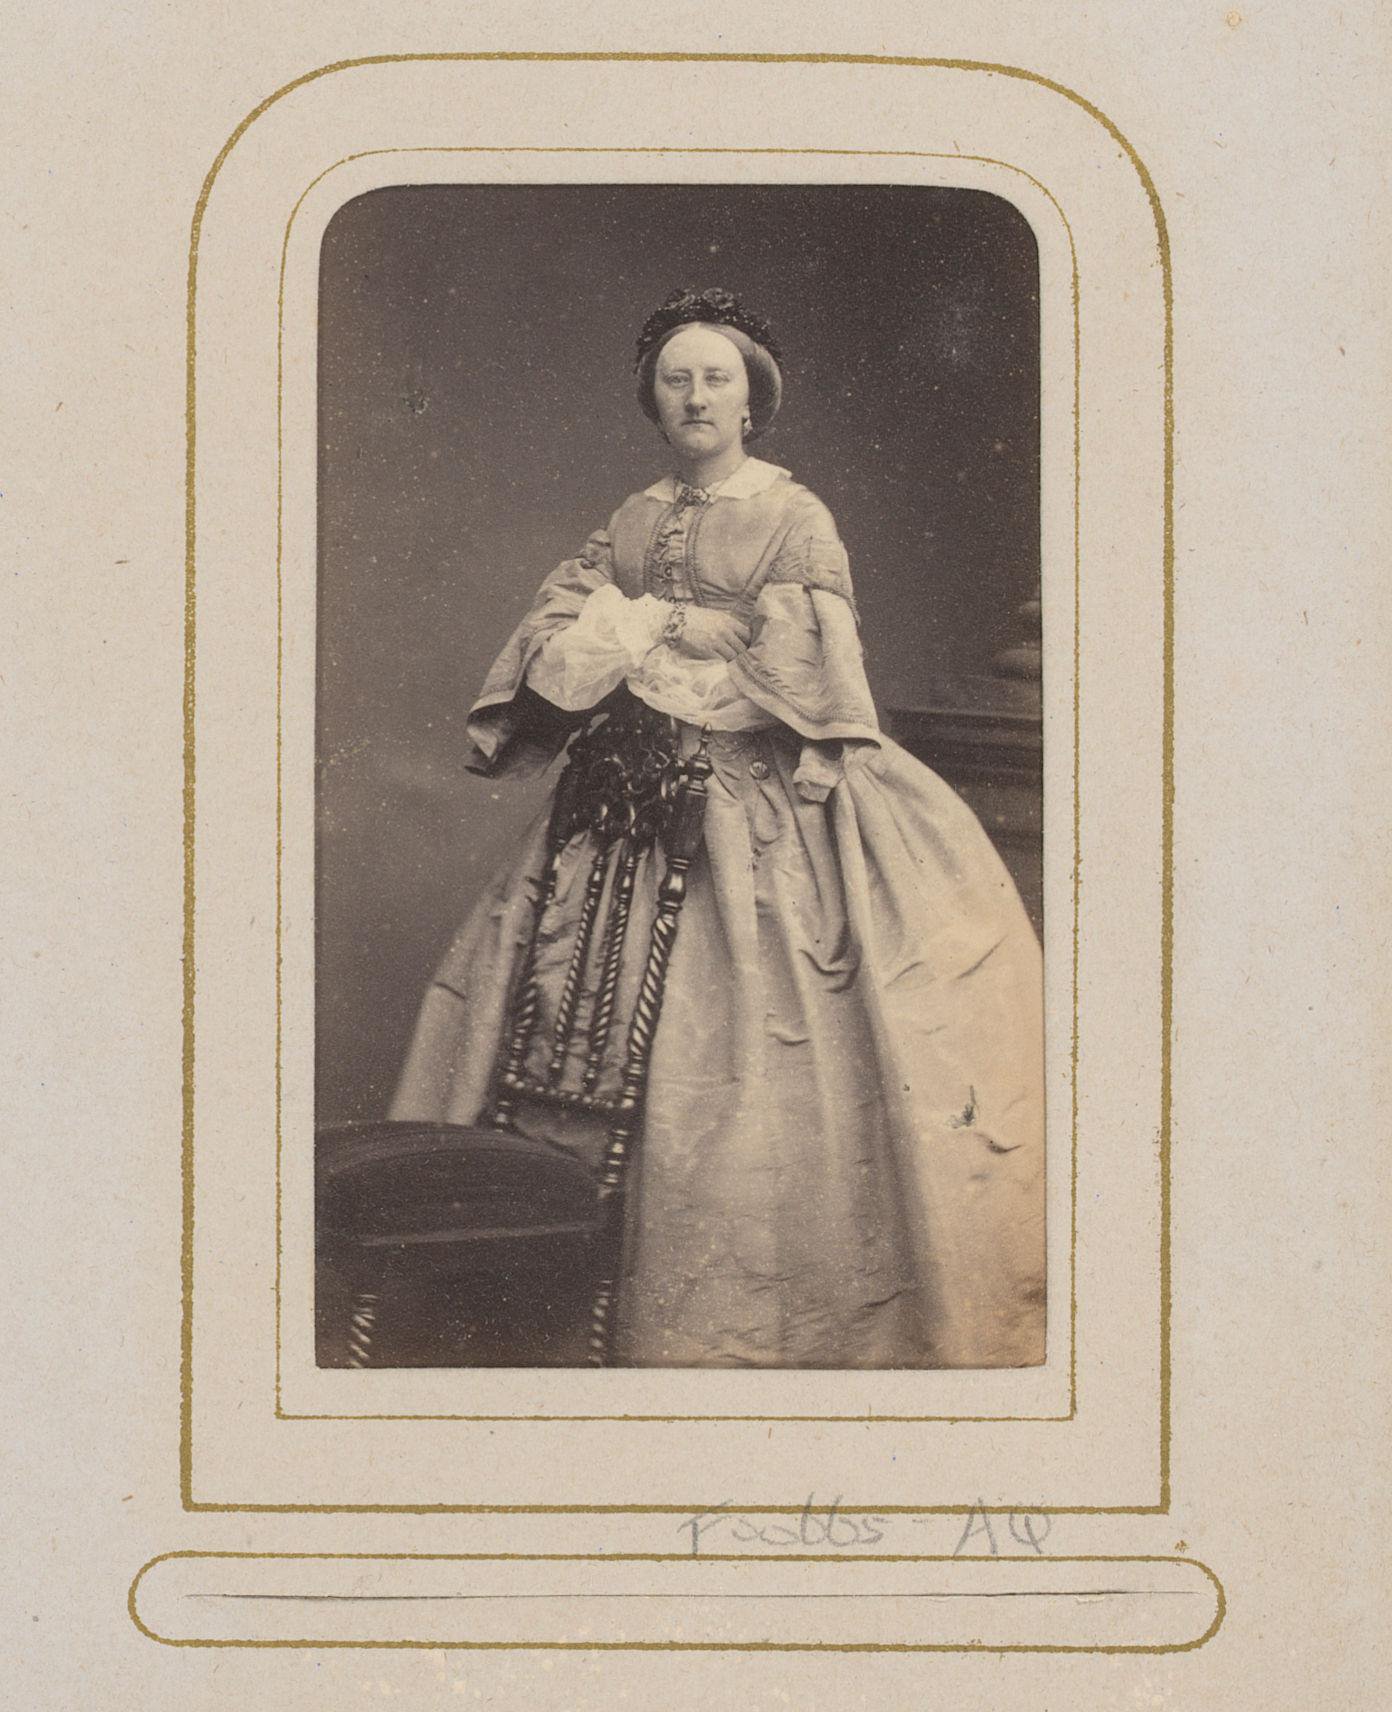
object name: carte de visite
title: Portret van een vrouw met muts leunend op stoel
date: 1857-1864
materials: cardboard, photographic support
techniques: albumen print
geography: amsterdam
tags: historical persons - bb - woman, head-gear: cap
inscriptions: inscription: ‘Photogr. Atelier/ Wegner & Mottu/ Prinsengracht BB.439/ Amsterdam’